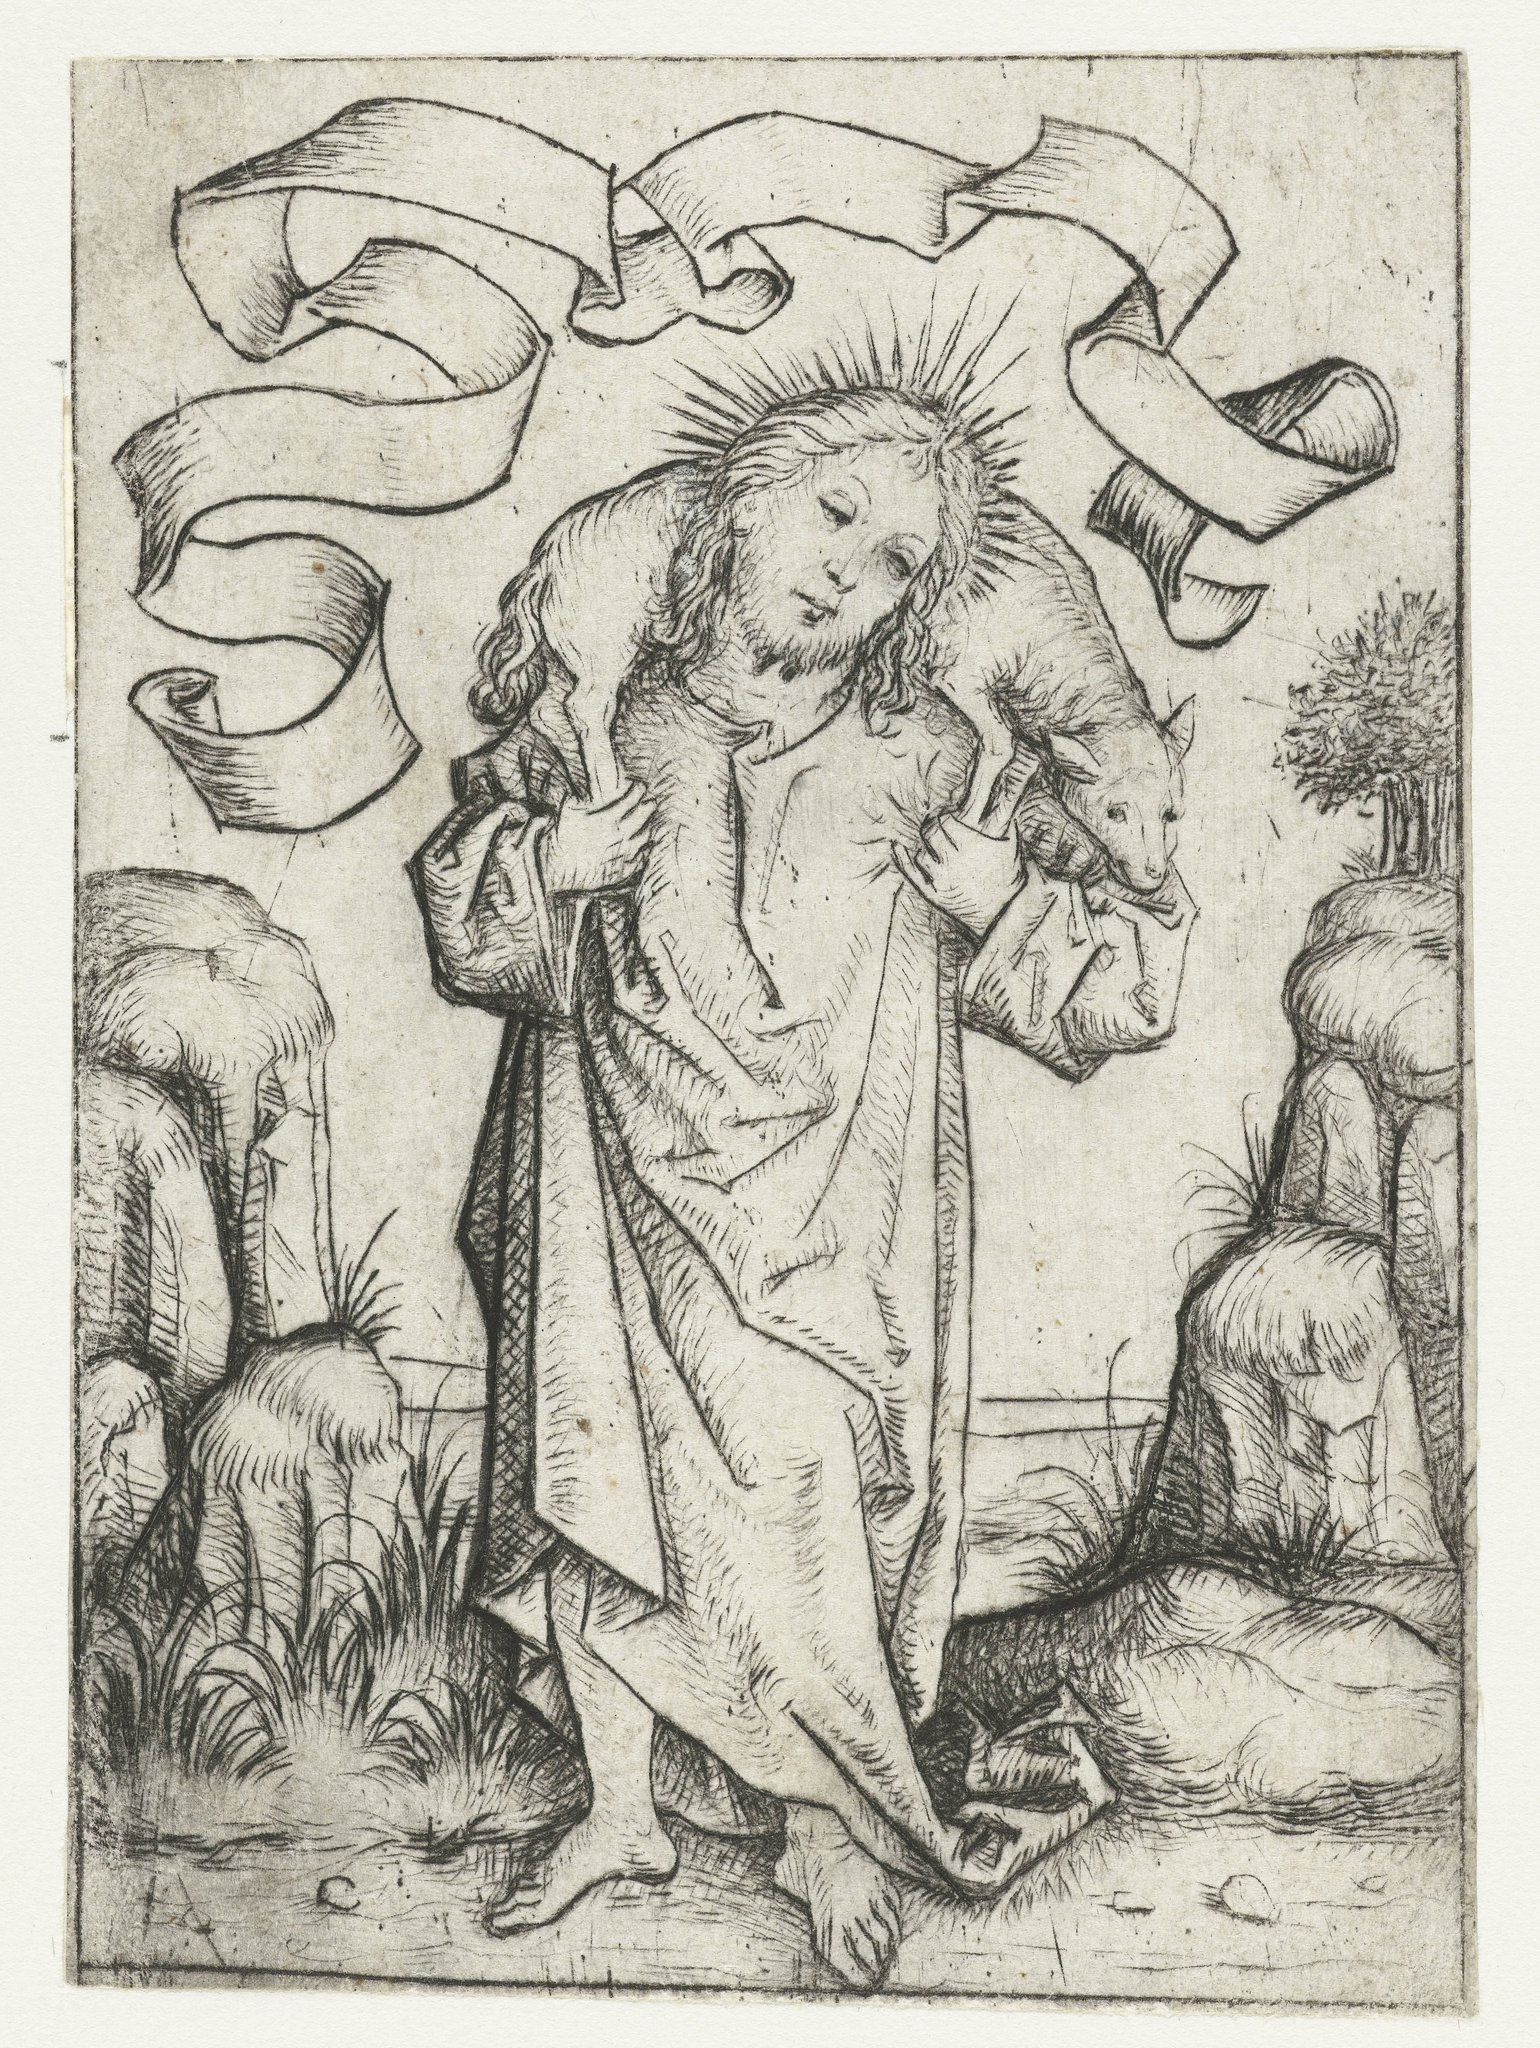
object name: print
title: Christus als de Goede Herder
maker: meester van het amsterdamse kabinet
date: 1473-1477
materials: paper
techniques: drypoint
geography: germany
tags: the good shepherd (christ) defending his sheep against wolves; 'i am the good shepherd' (john 10:1-16)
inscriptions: collector's mark: Lugt 2228a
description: Christus met lam op de schouders, lege banderol boven hoofd.